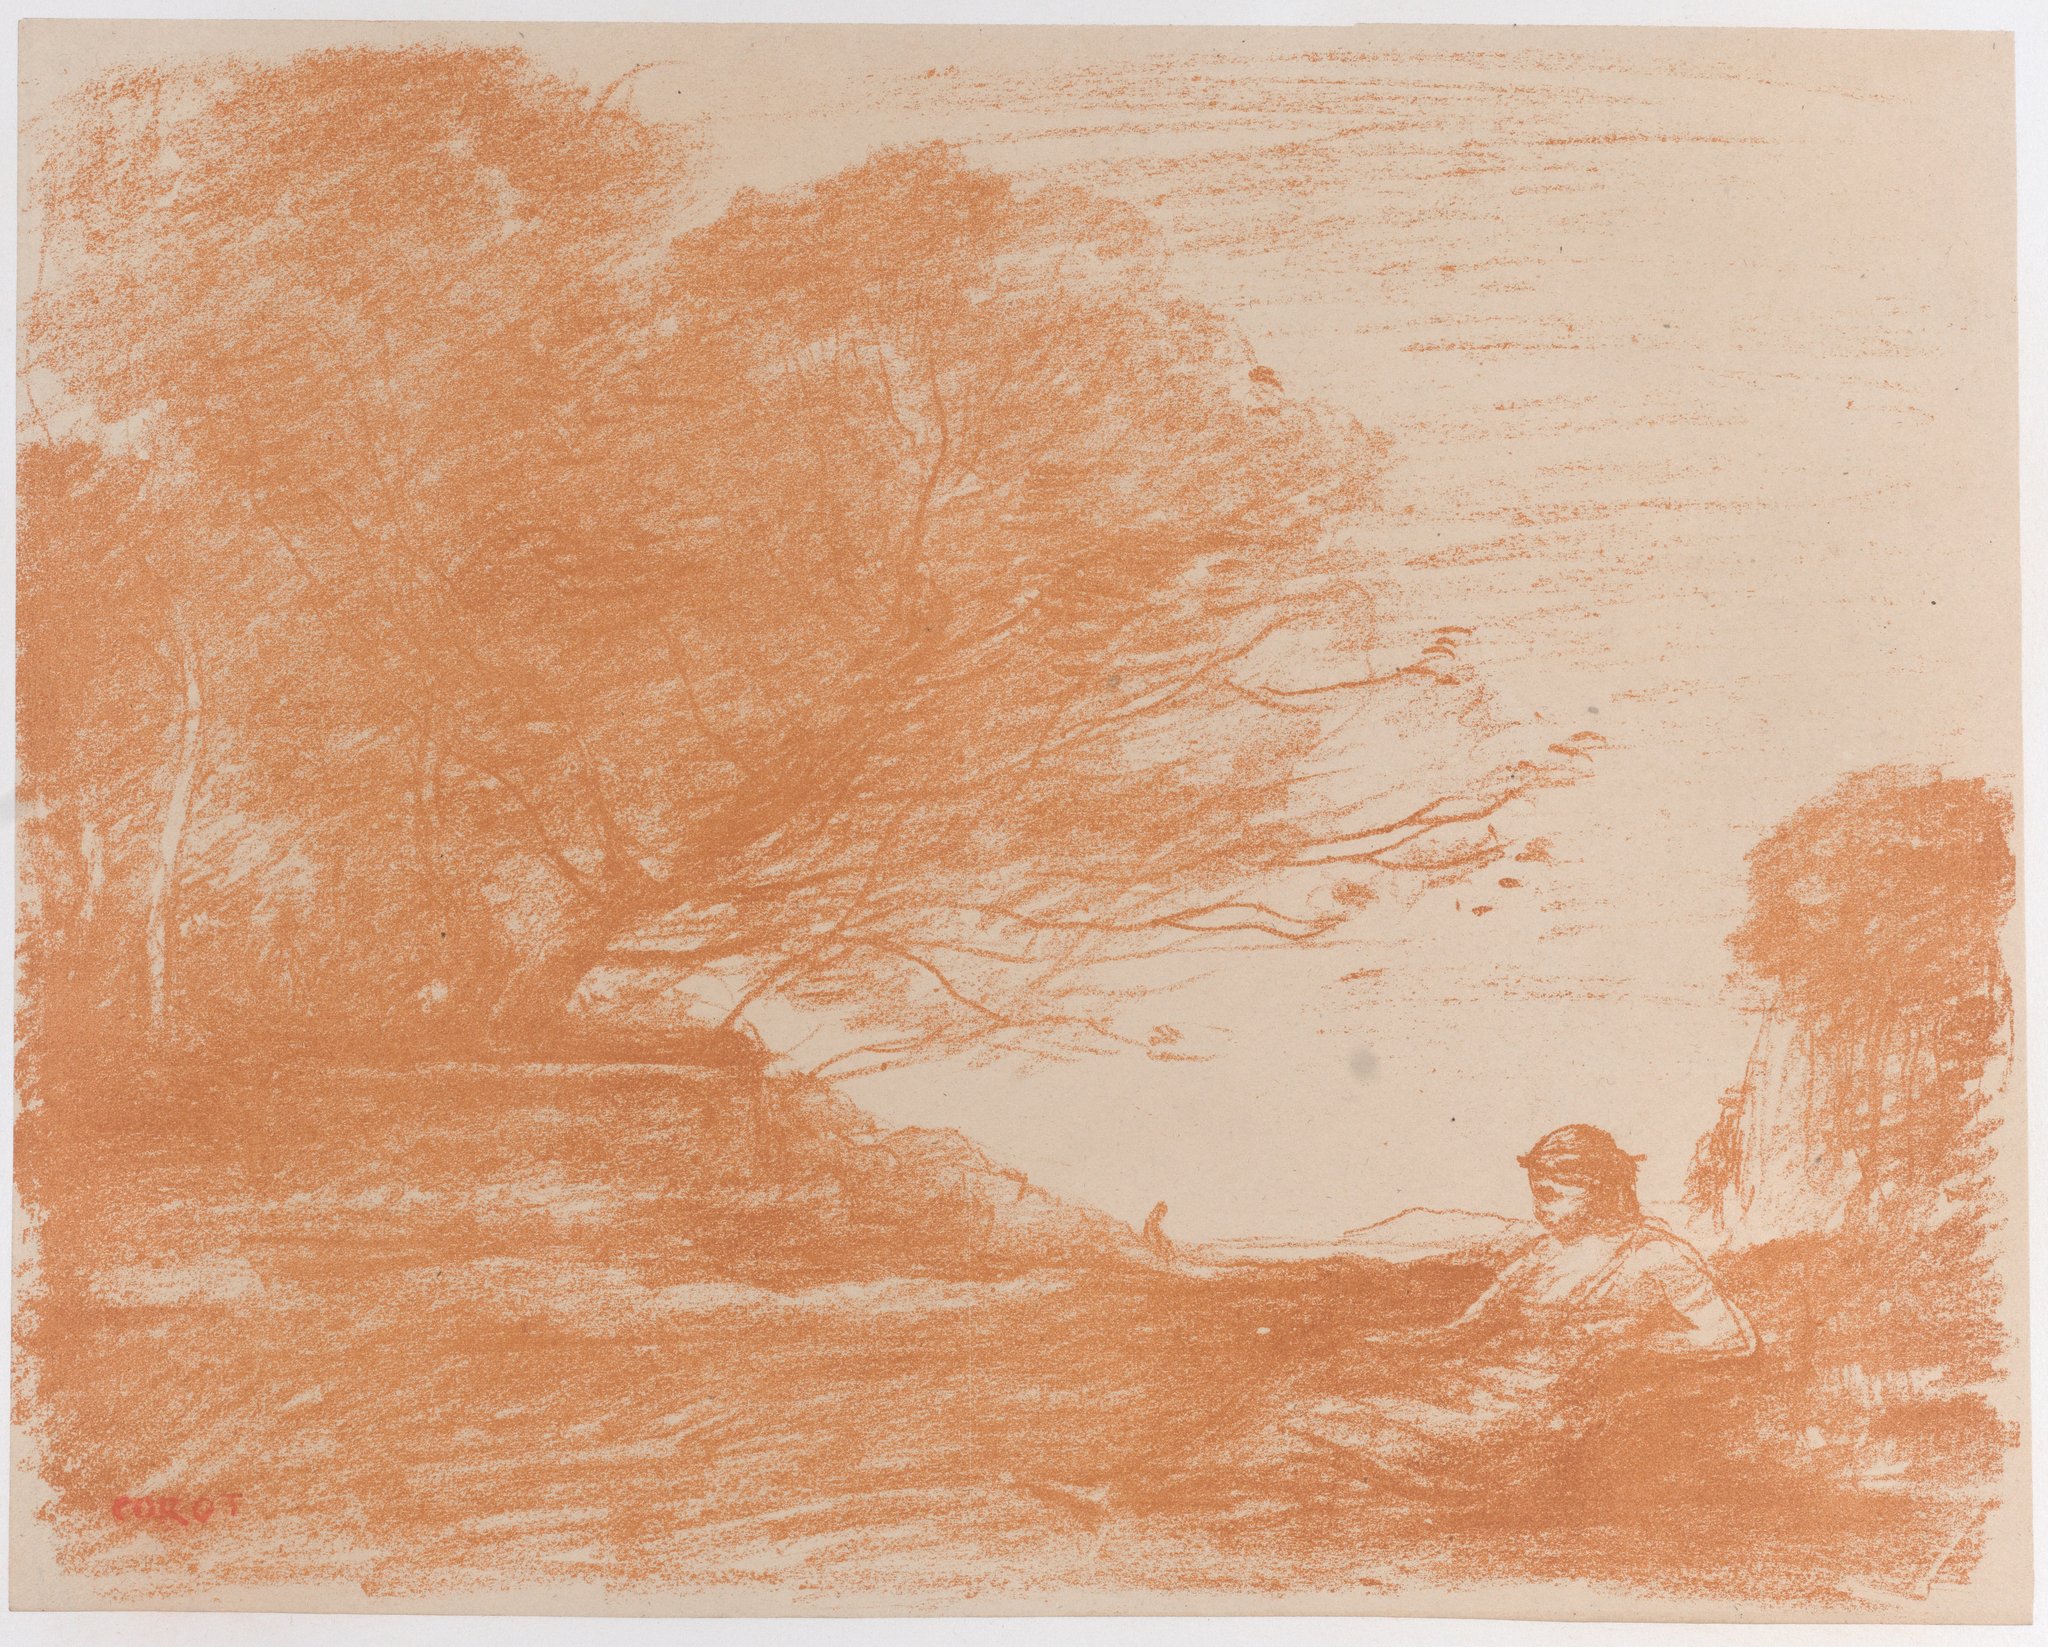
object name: print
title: Sappho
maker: jean-baptiste-camille corot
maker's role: artist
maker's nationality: french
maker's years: 1796-1875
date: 1871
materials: ink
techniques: lithograph, printing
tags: landscapes,trees